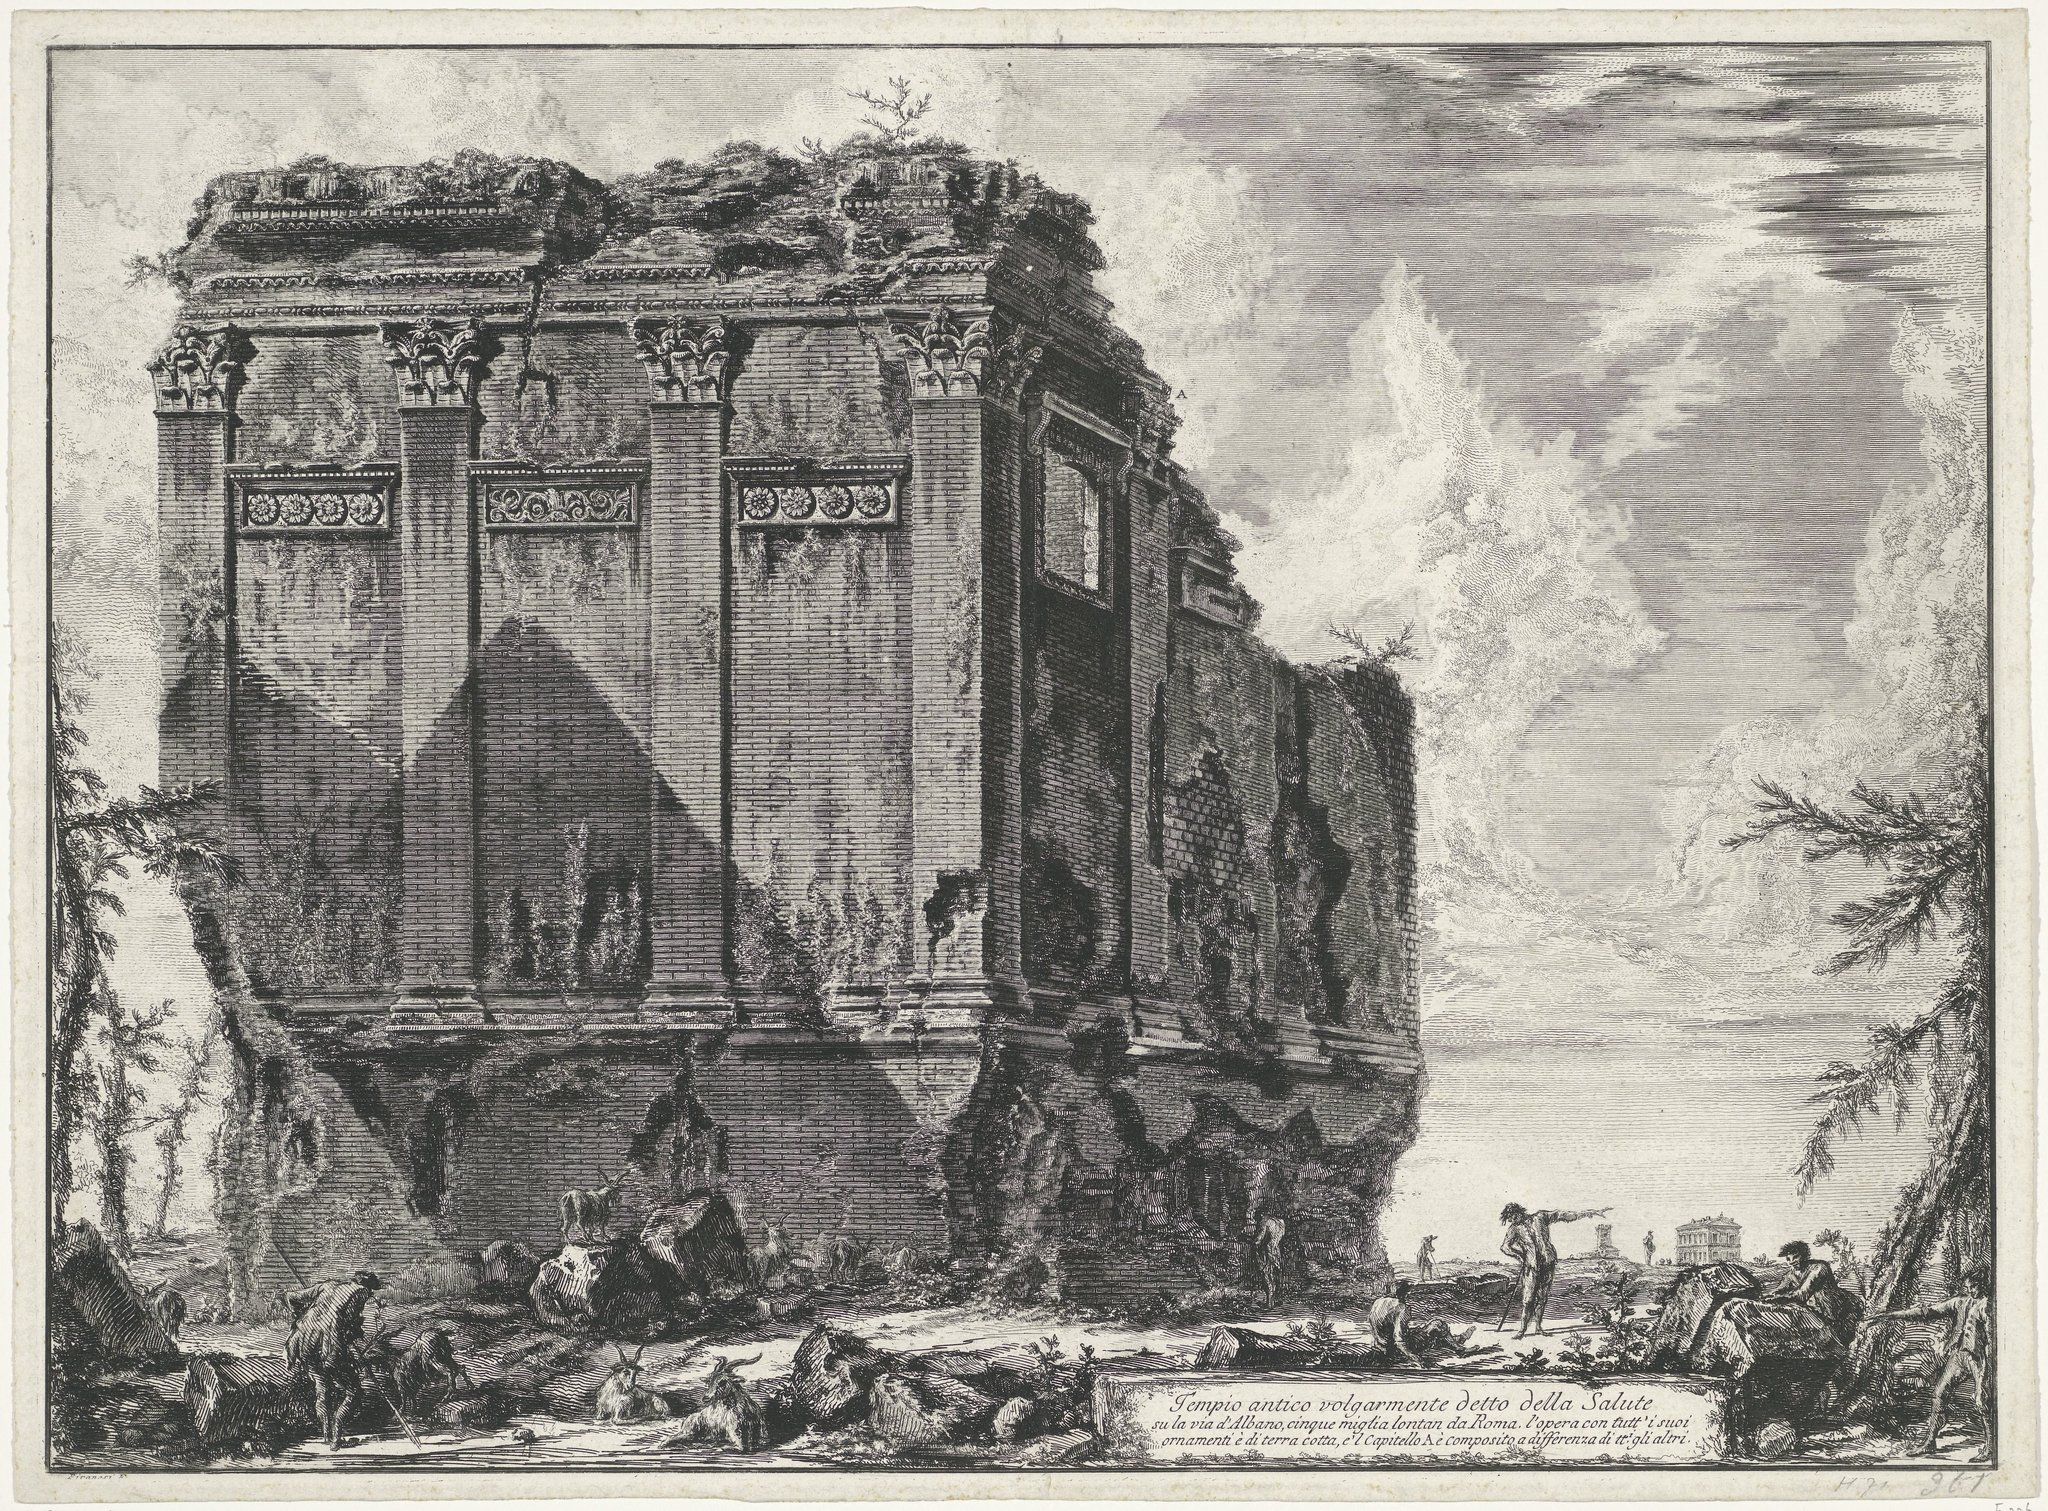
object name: print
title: Vedute di Roma disegnate ed incise da Giambattista Piranesi architetto Ve(nez)iano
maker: giovanni battista piranesi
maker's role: designer, draughtsman, print maker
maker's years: 1720-1778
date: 1748-1778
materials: paper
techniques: etching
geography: rome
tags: city-view, and landscape with man-made constructions, ruin of a building ~ architecture, landscape with ruins, temple, shrine ~ roman religion, rome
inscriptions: collector's mark: Lugt 2228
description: Deze prent maakt deel uit van de serie 'Vedute di Roma'. Piranesi werkte aan deze 135 platen tellende serie tussen 1748 en zijn dood in 1778. Francesco Piranesi voegde later nog twee prenten toe aan de reeks van zijn vader.